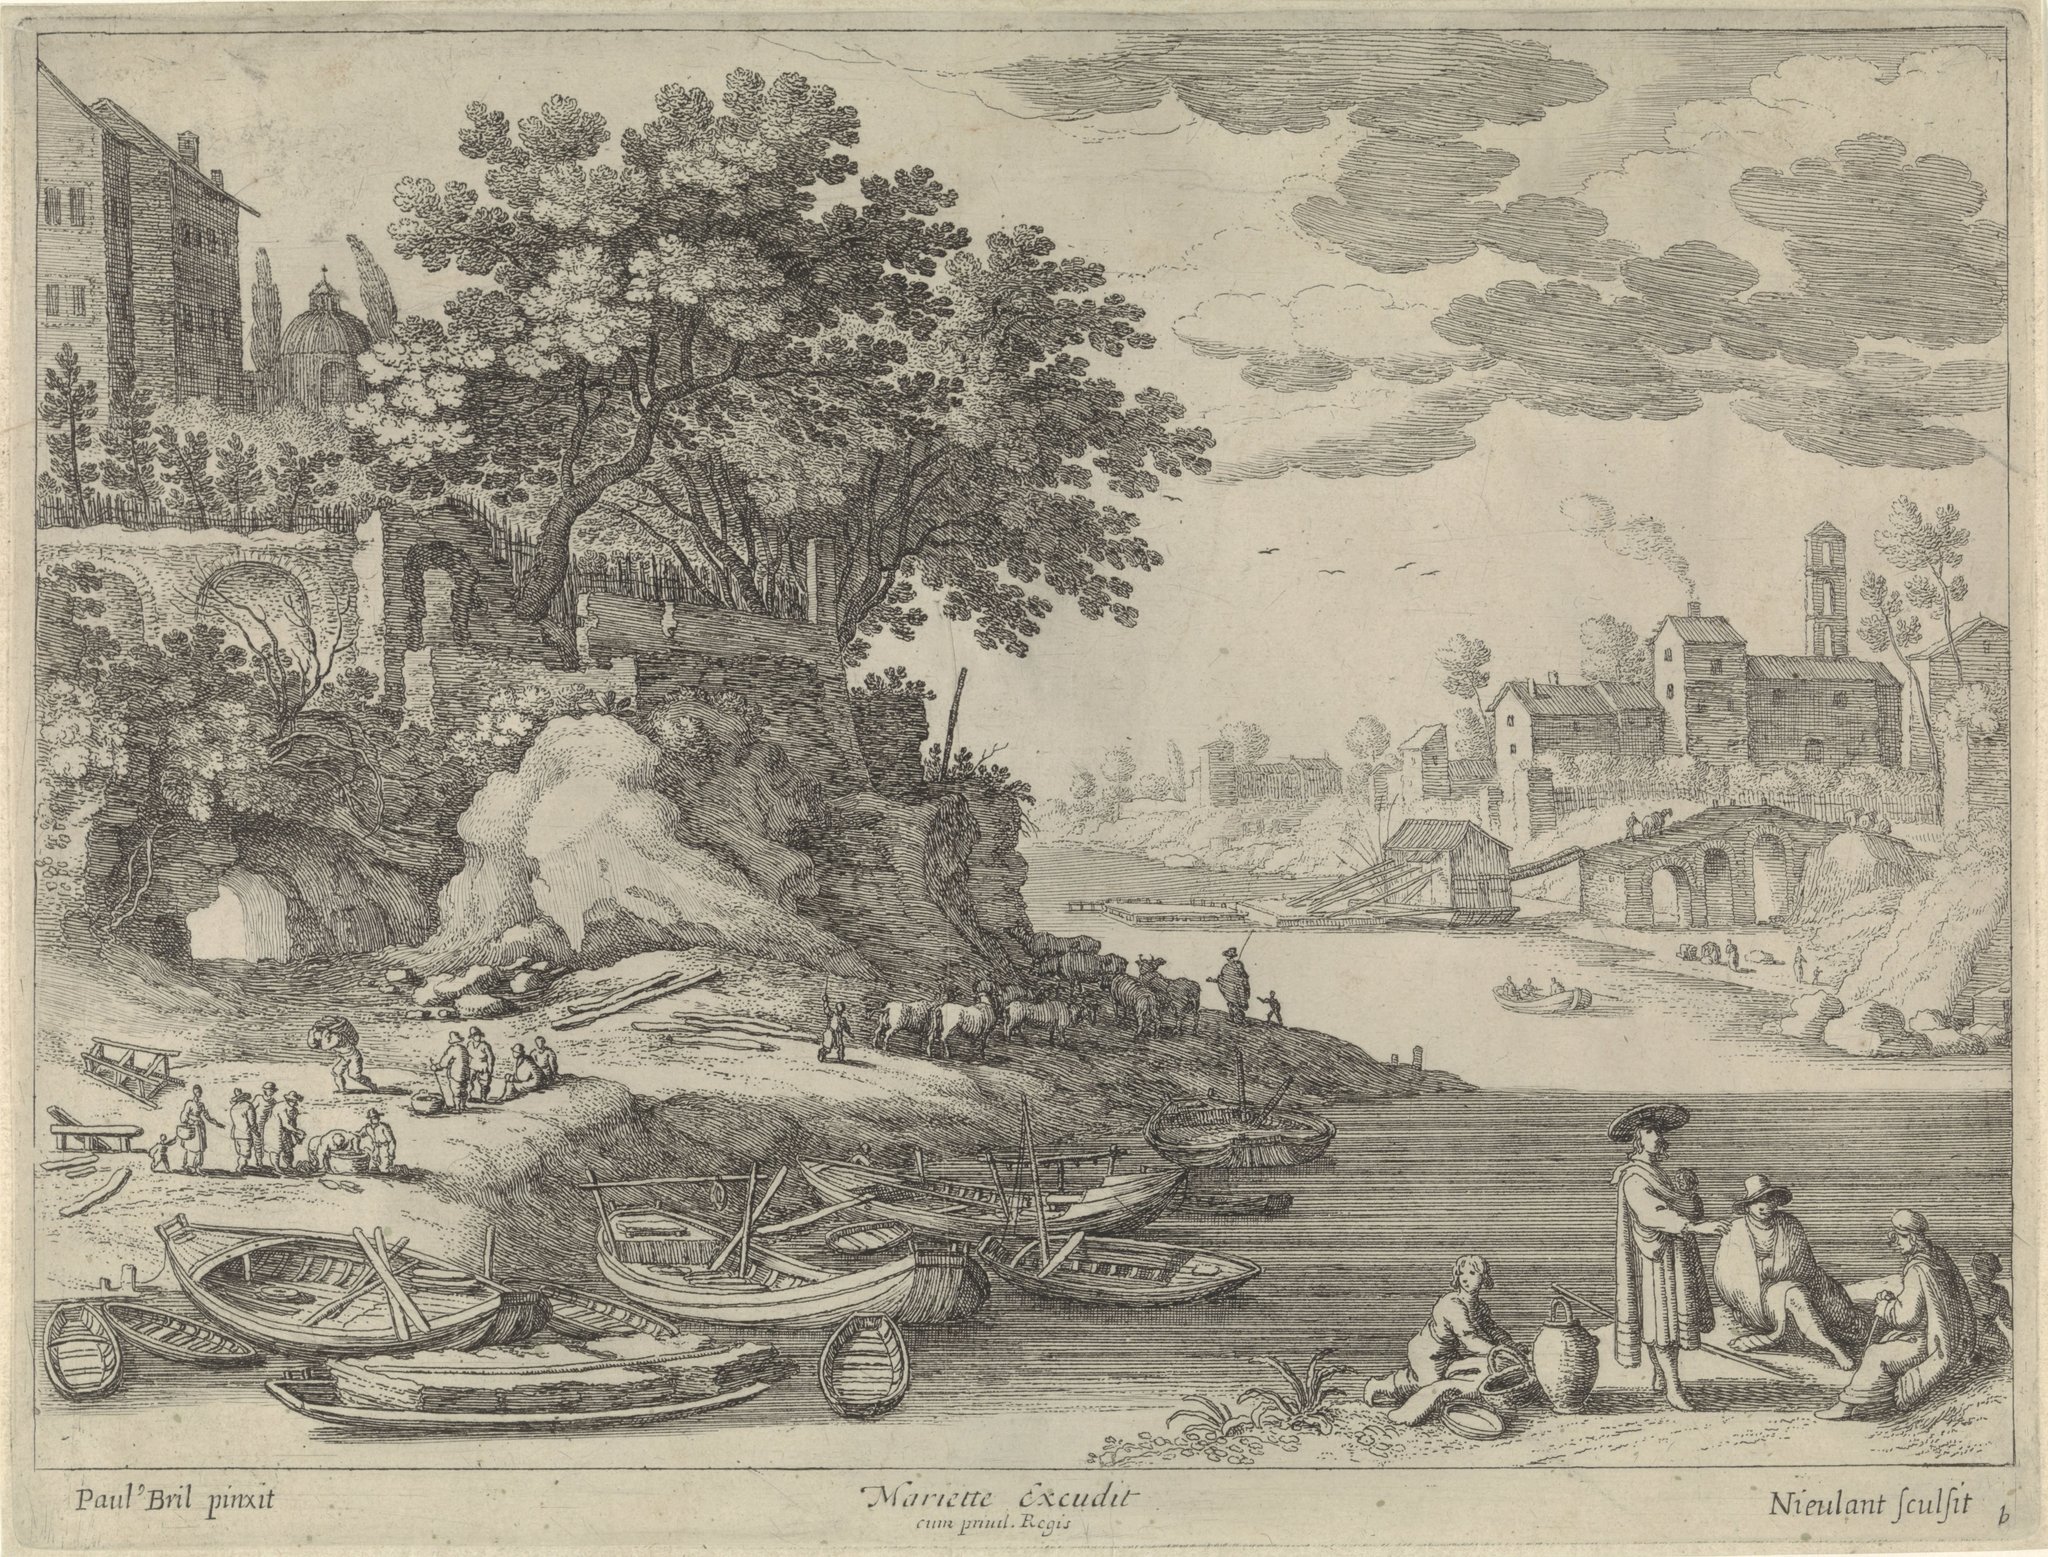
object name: print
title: Haven met roeiboten, figuren en vee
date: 1594-1635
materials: paper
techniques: engraving, etching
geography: paris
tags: harbour, river, rowing-boat, canoe, etc.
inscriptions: collector's mark: Lugt 2228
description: Haven aan een rivier met aangemeerde roeiboten. Op de linkeroever verschillende figuren en een kudde vee. Op de rechteroever staat een vrouw met een kind in een draagdoek bij enkele zittende figuren.